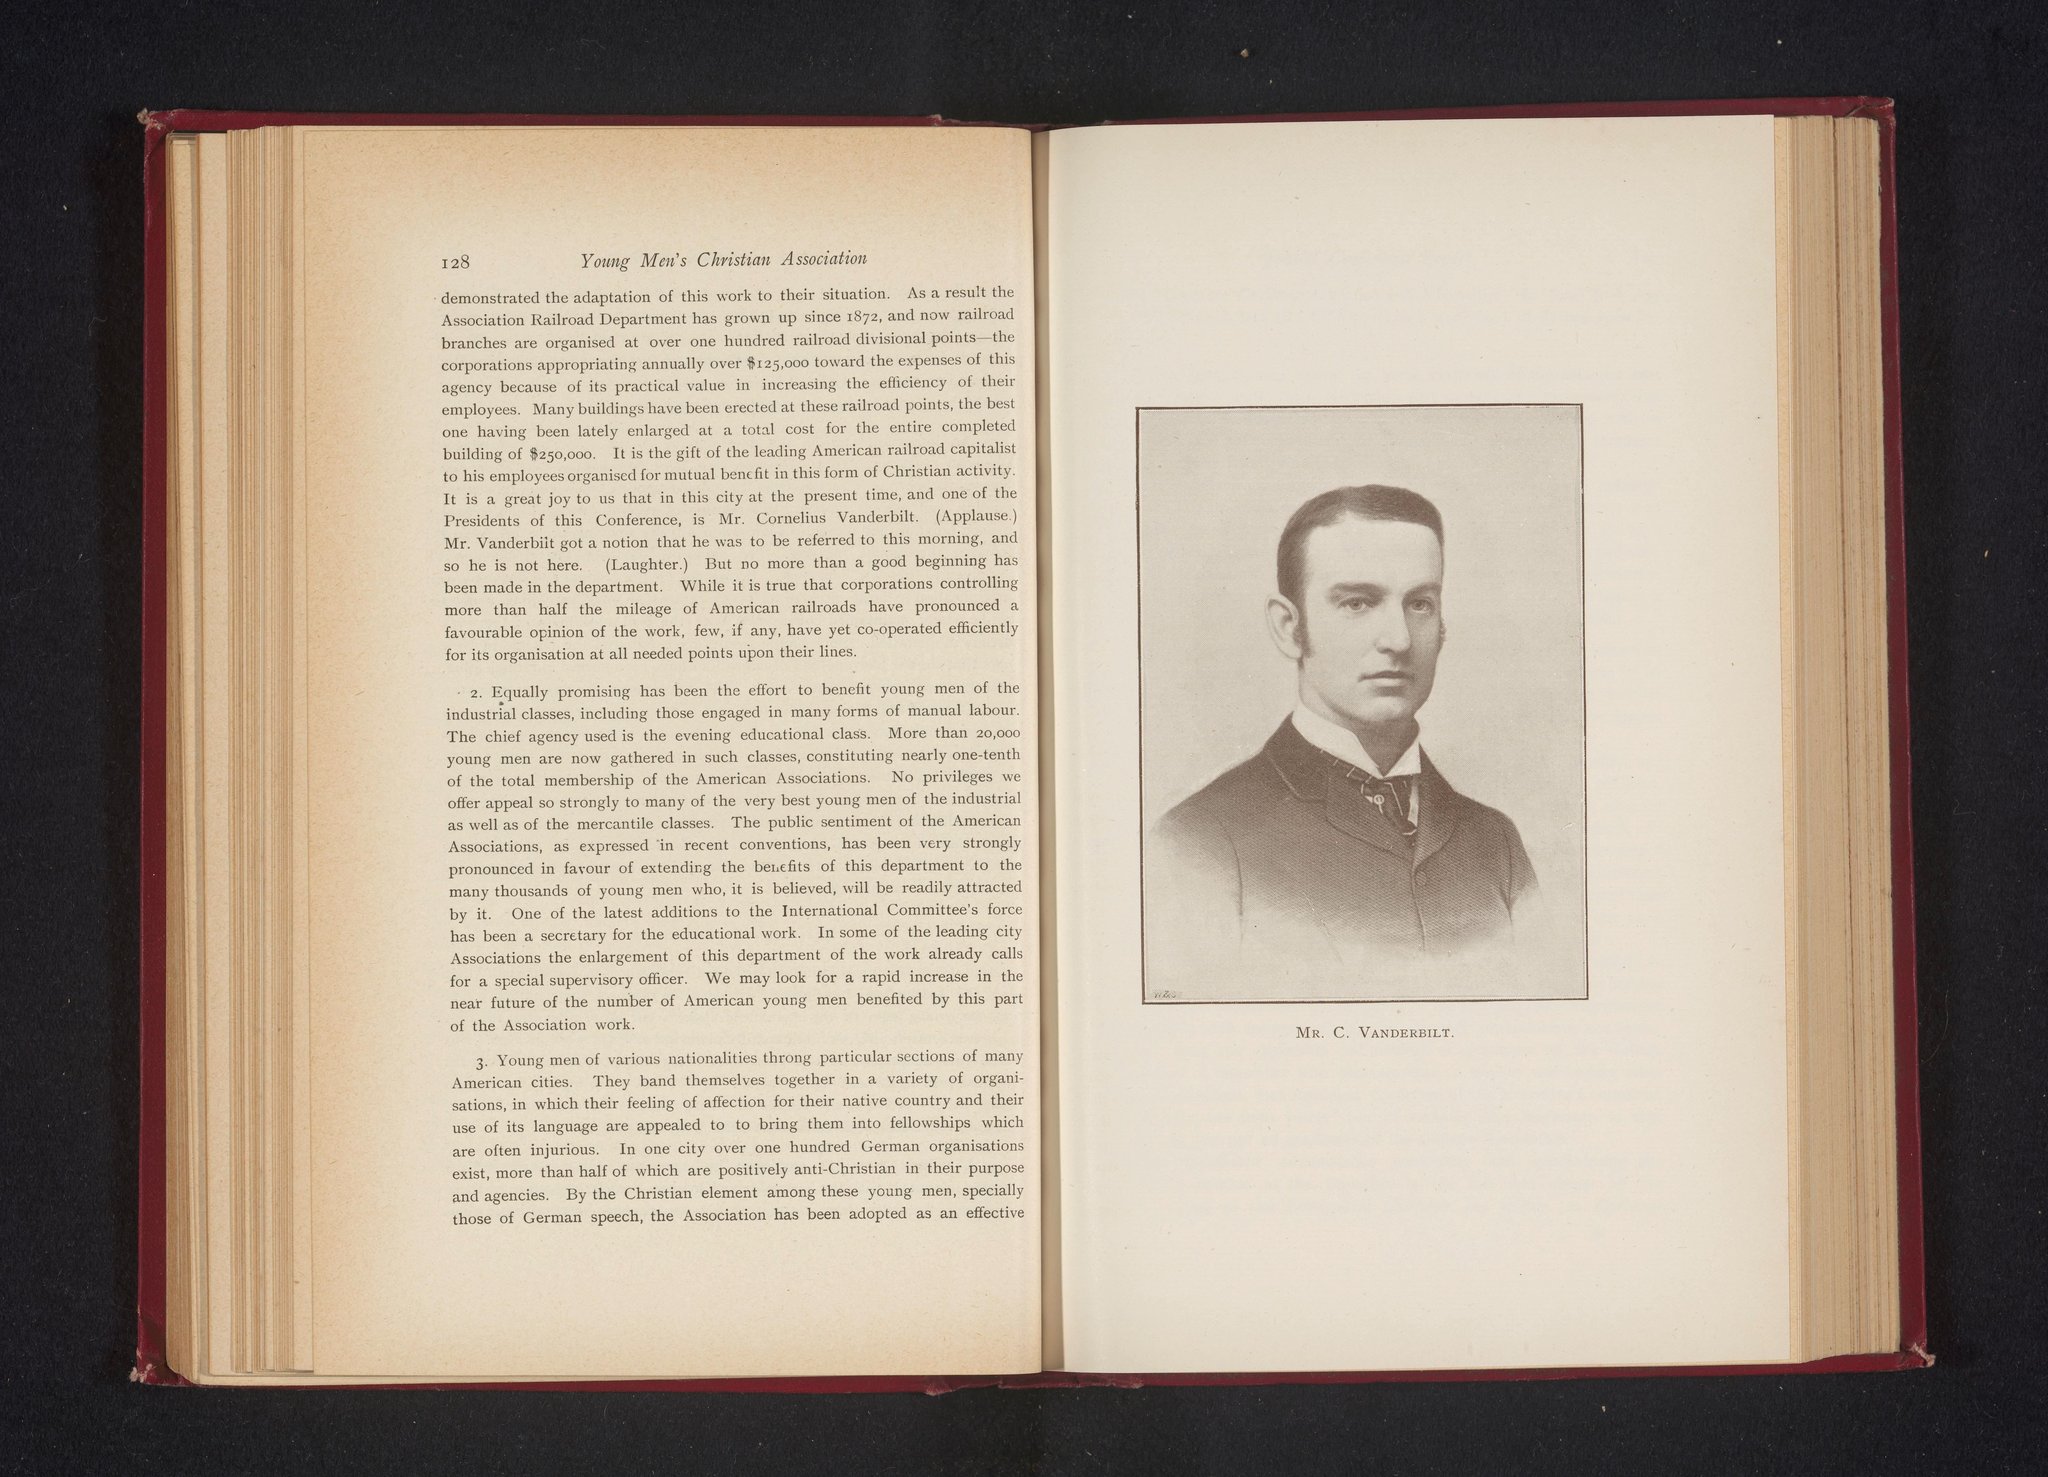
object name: page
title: Portret van Cornelius Vanderbilt II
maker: Anonymous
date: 1890-1895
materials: paper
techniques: autotype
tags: manhattan, historical persons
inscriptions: monogram: ‘w&s’